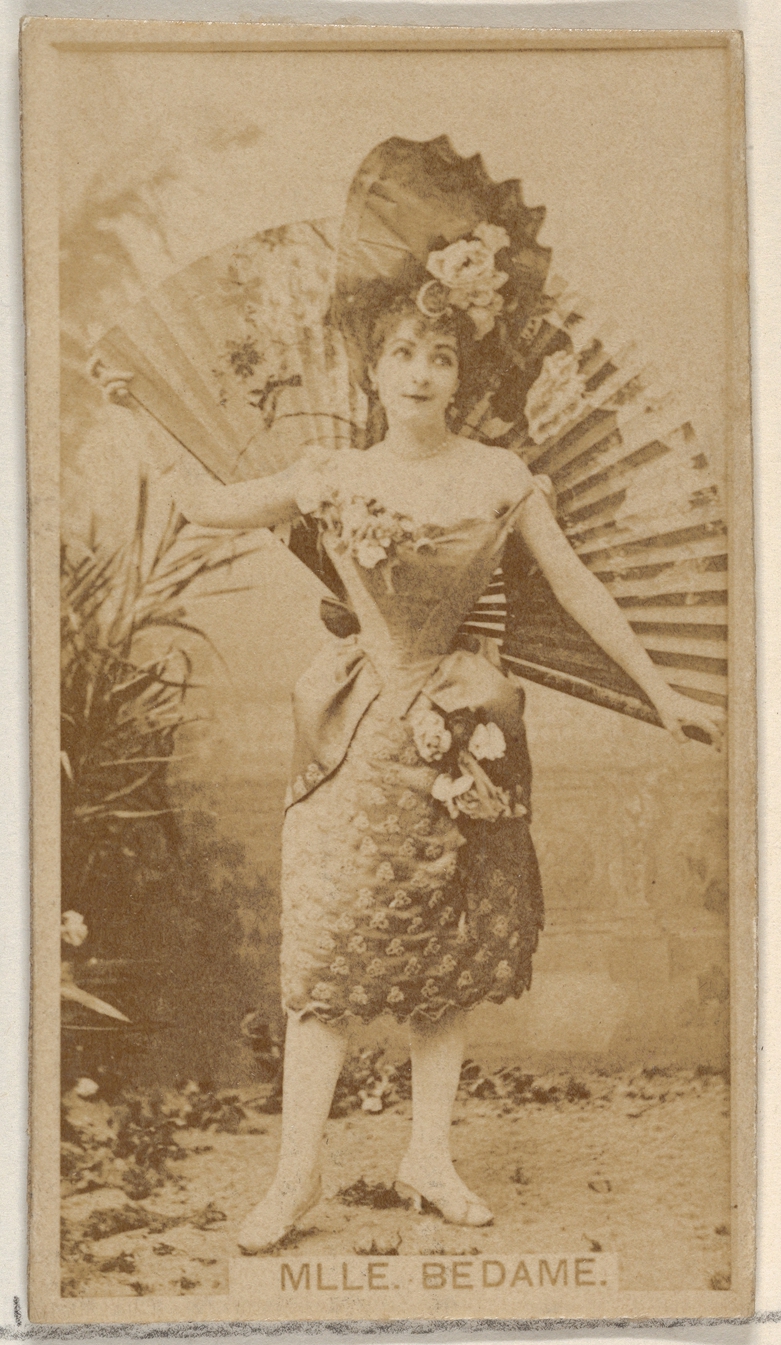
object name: photograph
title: Mlle. Bedame, from the Actors and Actresses series (N45, Type 8) for Virginia Brights Cigarettes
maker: allen & ginter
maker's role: publisher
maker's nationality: american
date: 1888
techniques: albumen silver print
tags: portraits,women,actresses